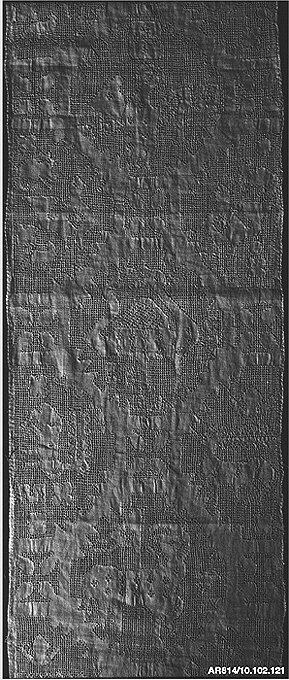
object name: drawnwork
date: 1601-1700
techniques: embroidery